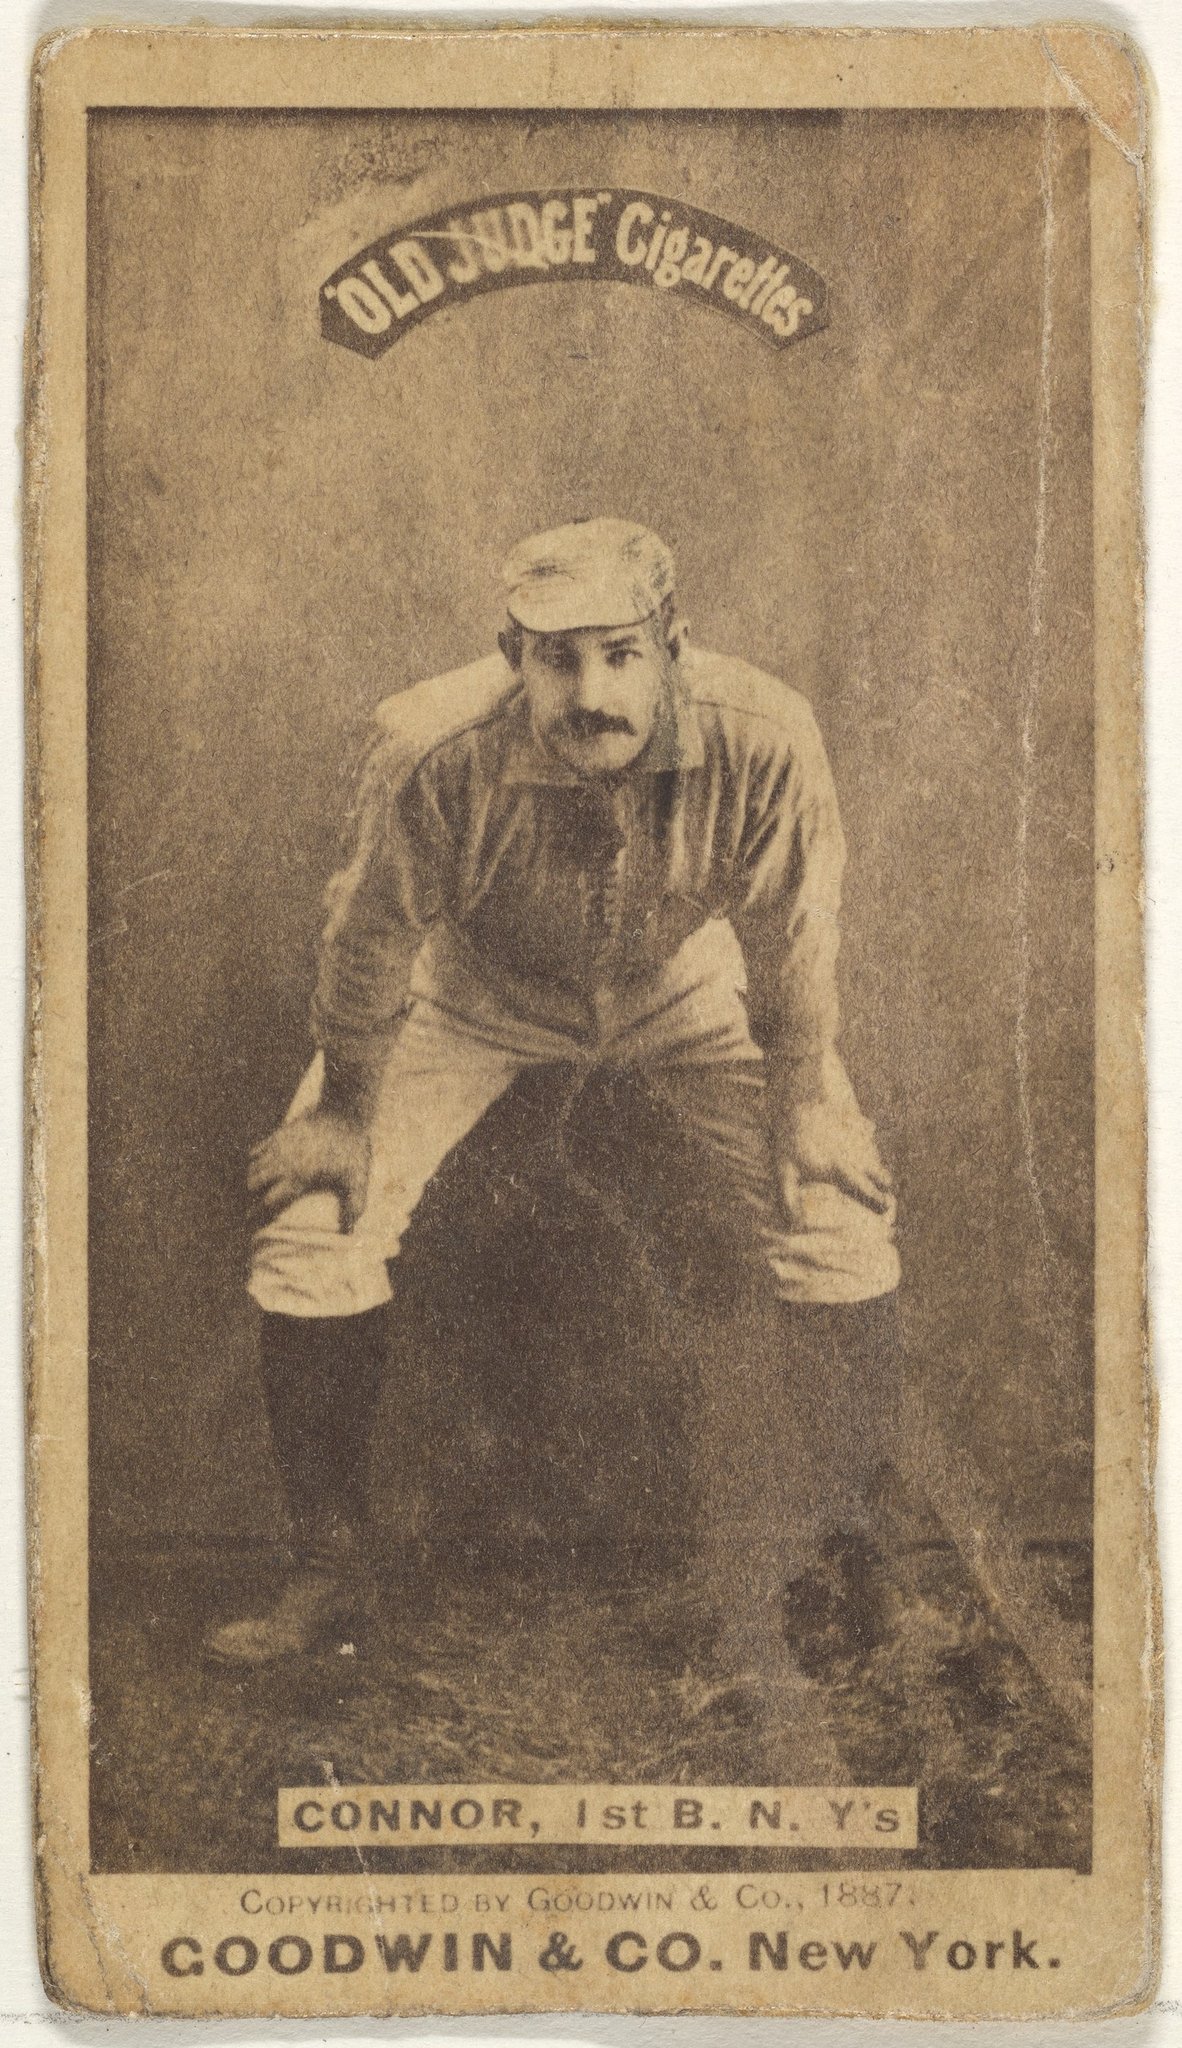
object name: baseball card, photograph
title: Roger Connor, 1st Base, New York, from the Old Judge series (N172) for Old Judge Cigarettes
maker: goodwin & company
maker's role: publisher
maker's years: 1850-1950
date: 1887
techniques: albumen silver print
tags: men,portraits,baseball,athletes